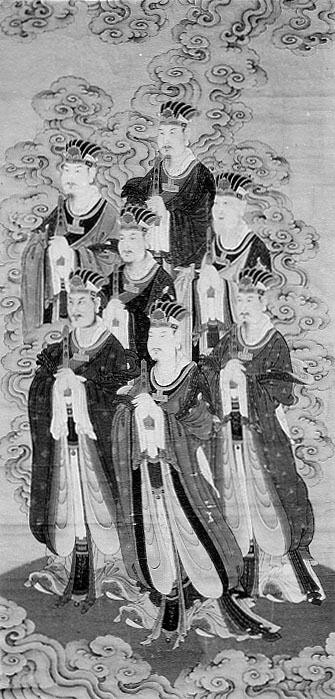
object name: hanging scroll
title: Seven Heavenly Kings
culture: chinese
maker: unidentified artist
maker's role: artist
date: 1368-1911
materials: silk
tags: kings,men